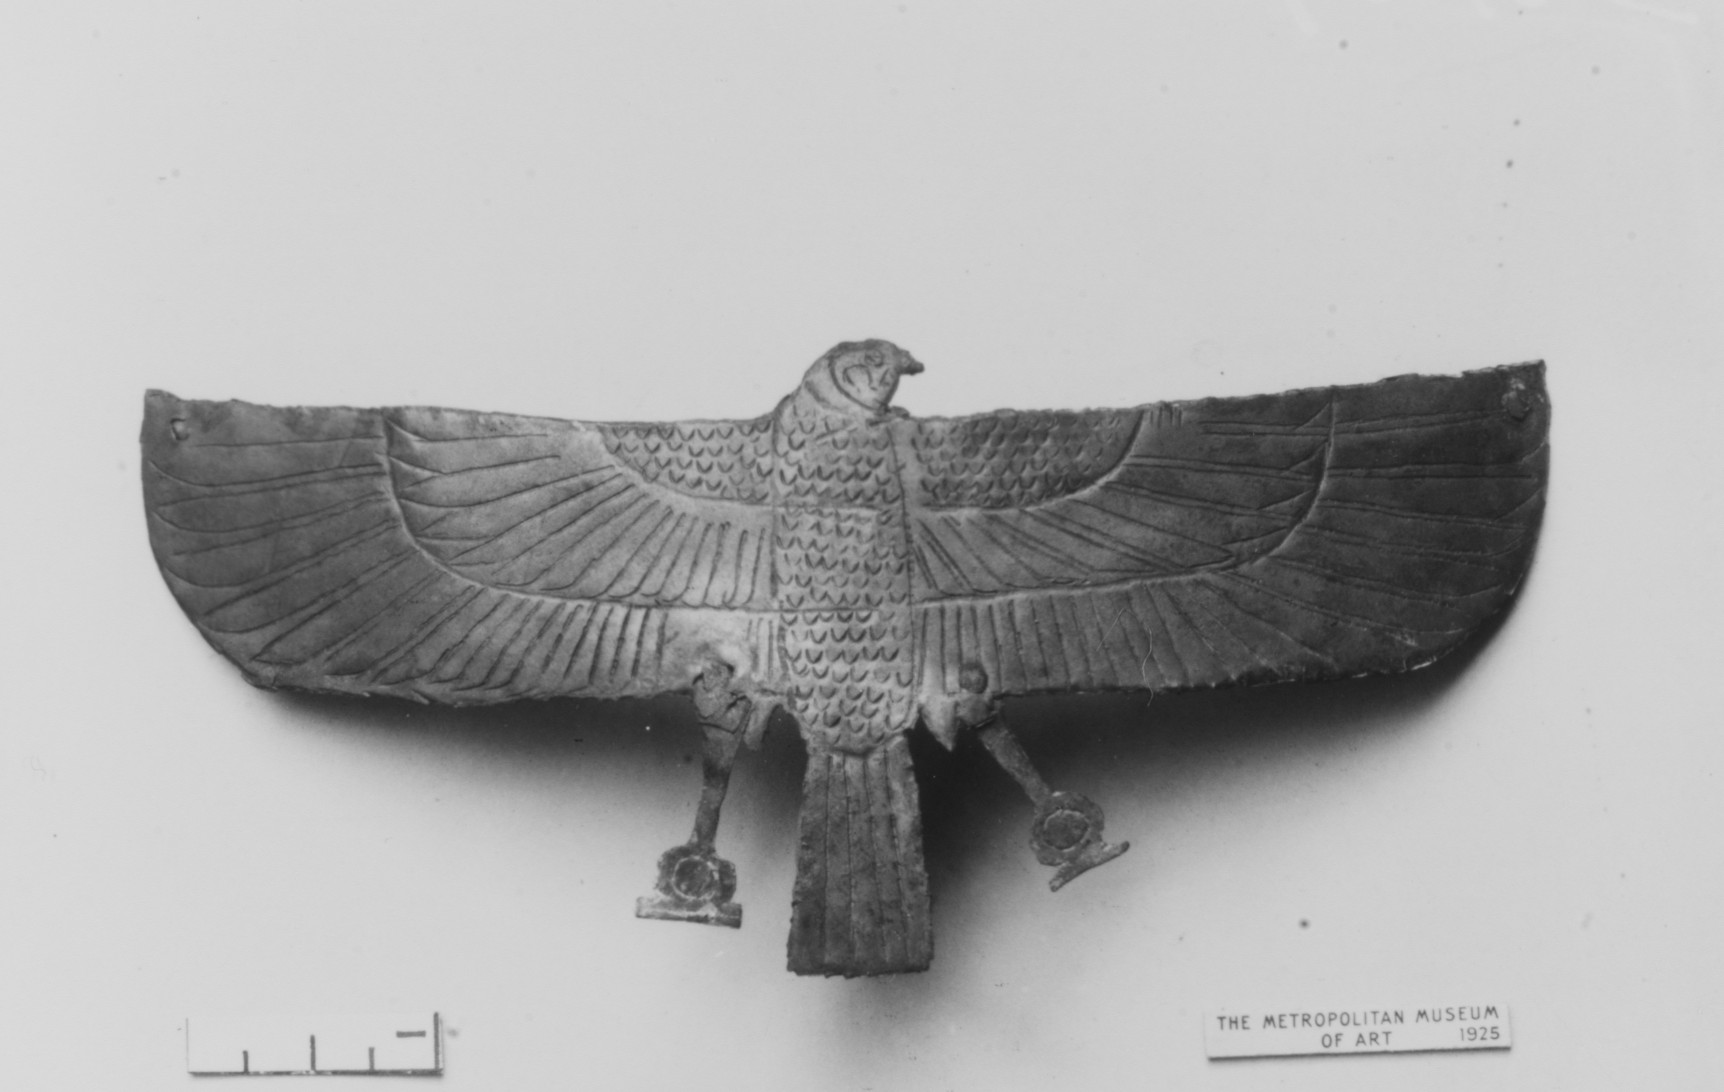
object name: pectoral, falcon, gautsoshen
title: Falcon Pectoral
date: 1000-945 BCE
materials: bronze, copper alloy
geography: egypt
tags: birds